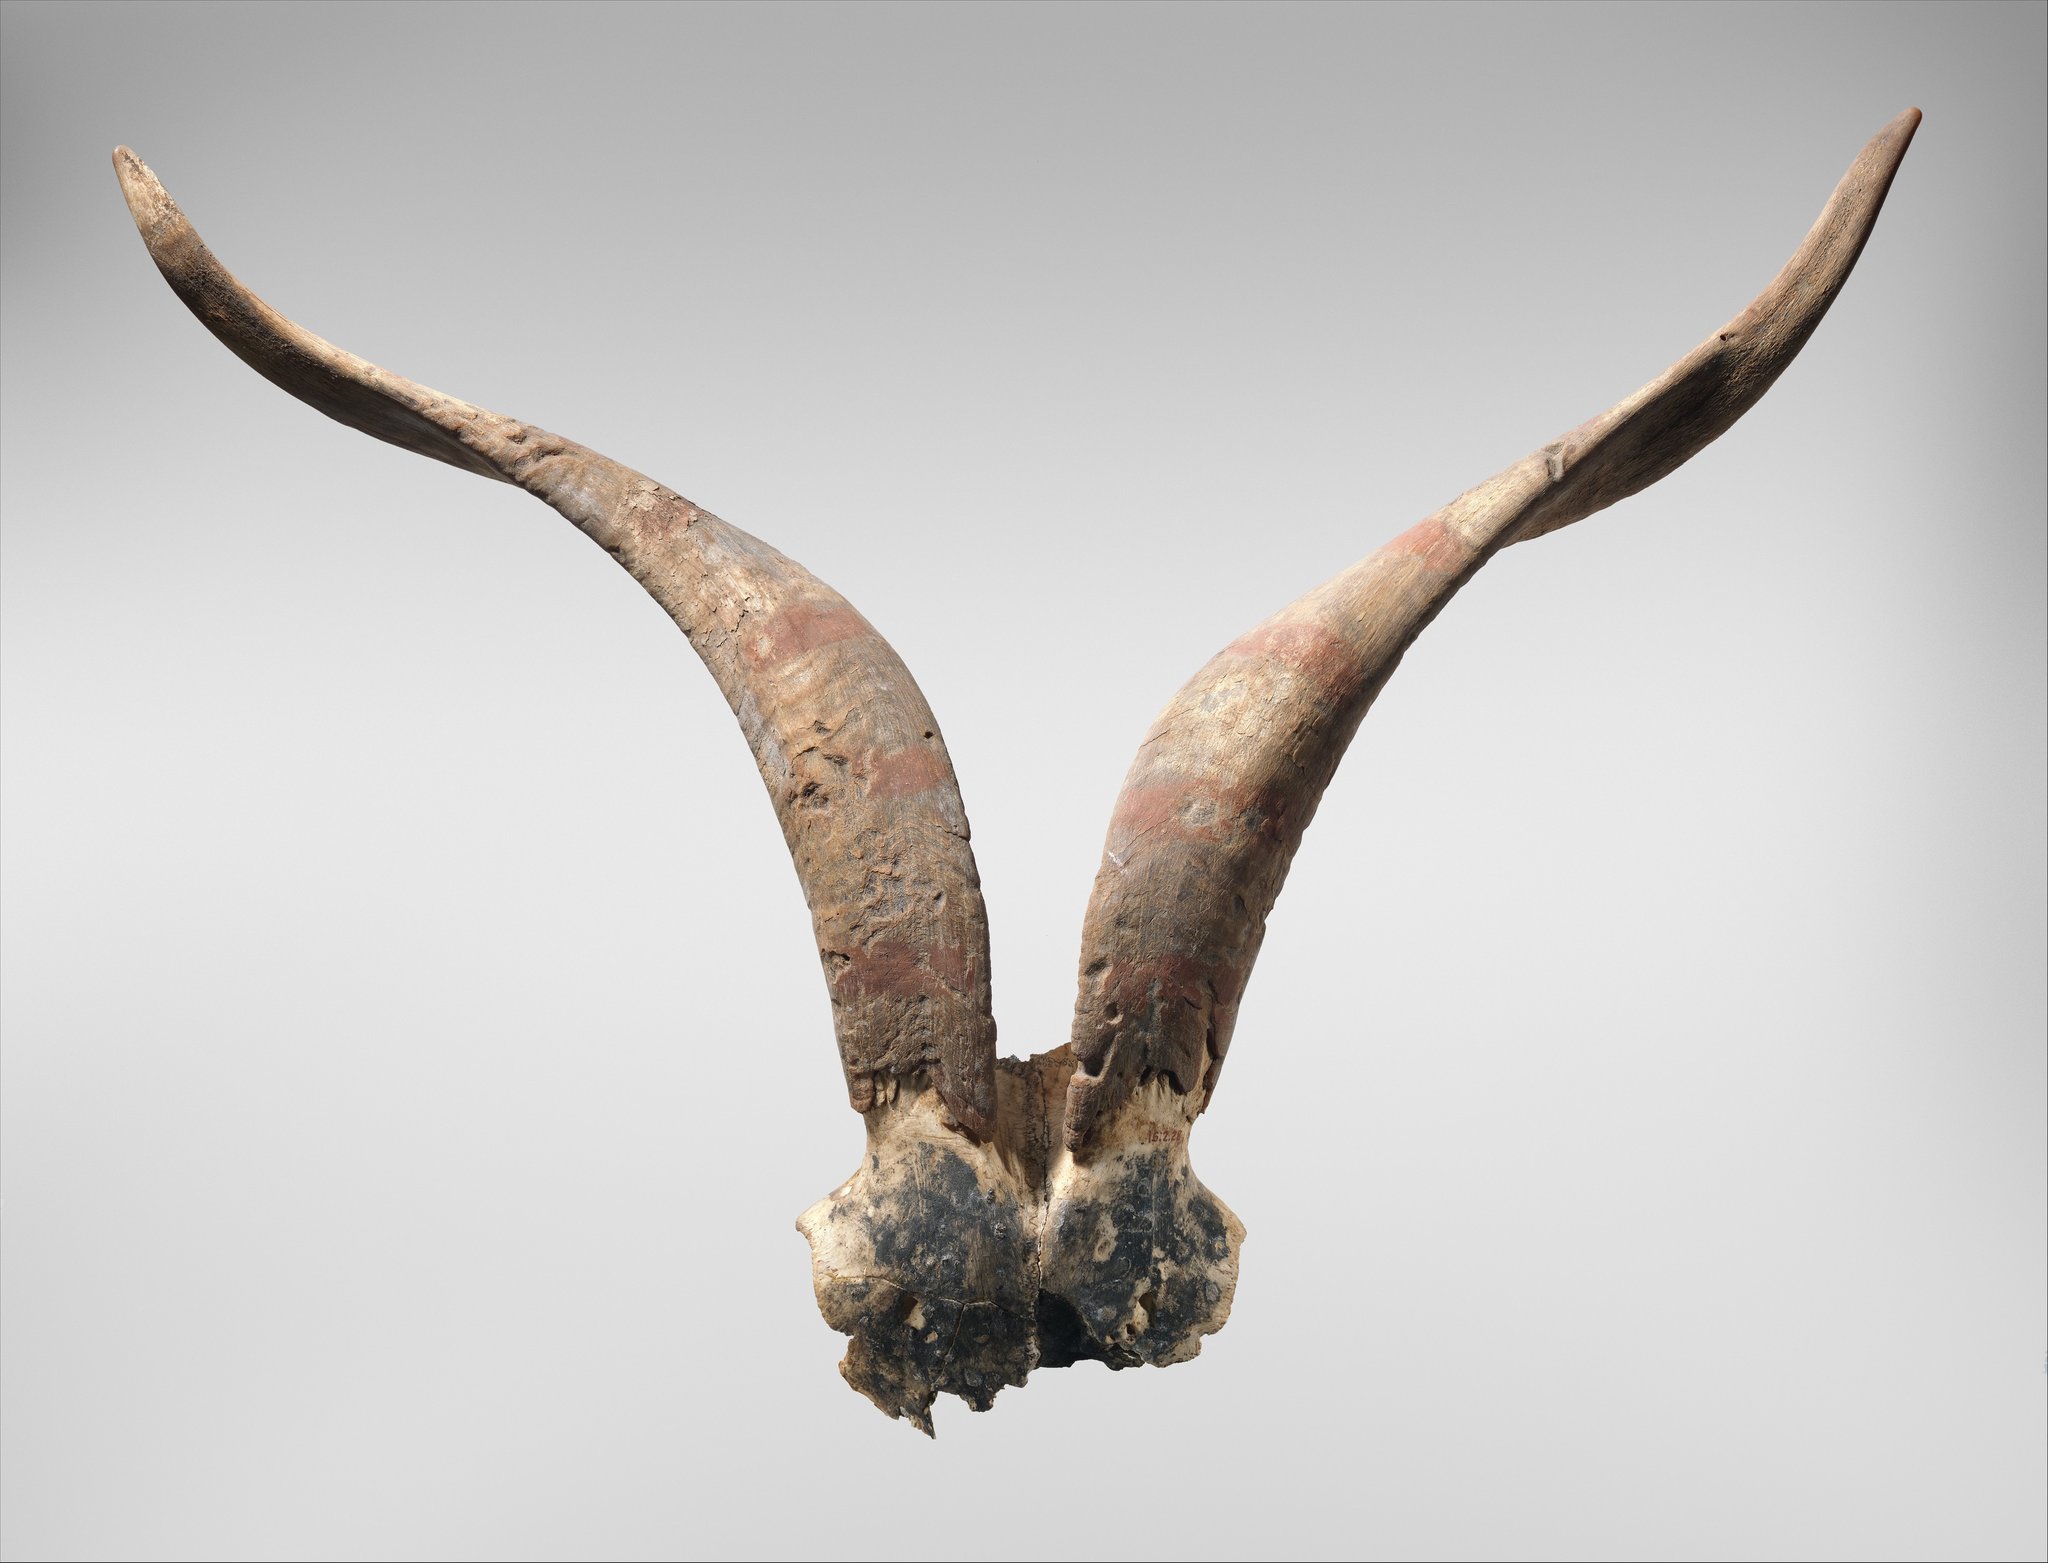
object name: bucranium, antler, horn, pan grave, medjayu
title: Bucranium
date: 1640-1550 BCE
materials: antler, bone, paint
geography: egypt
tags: animals,skulls